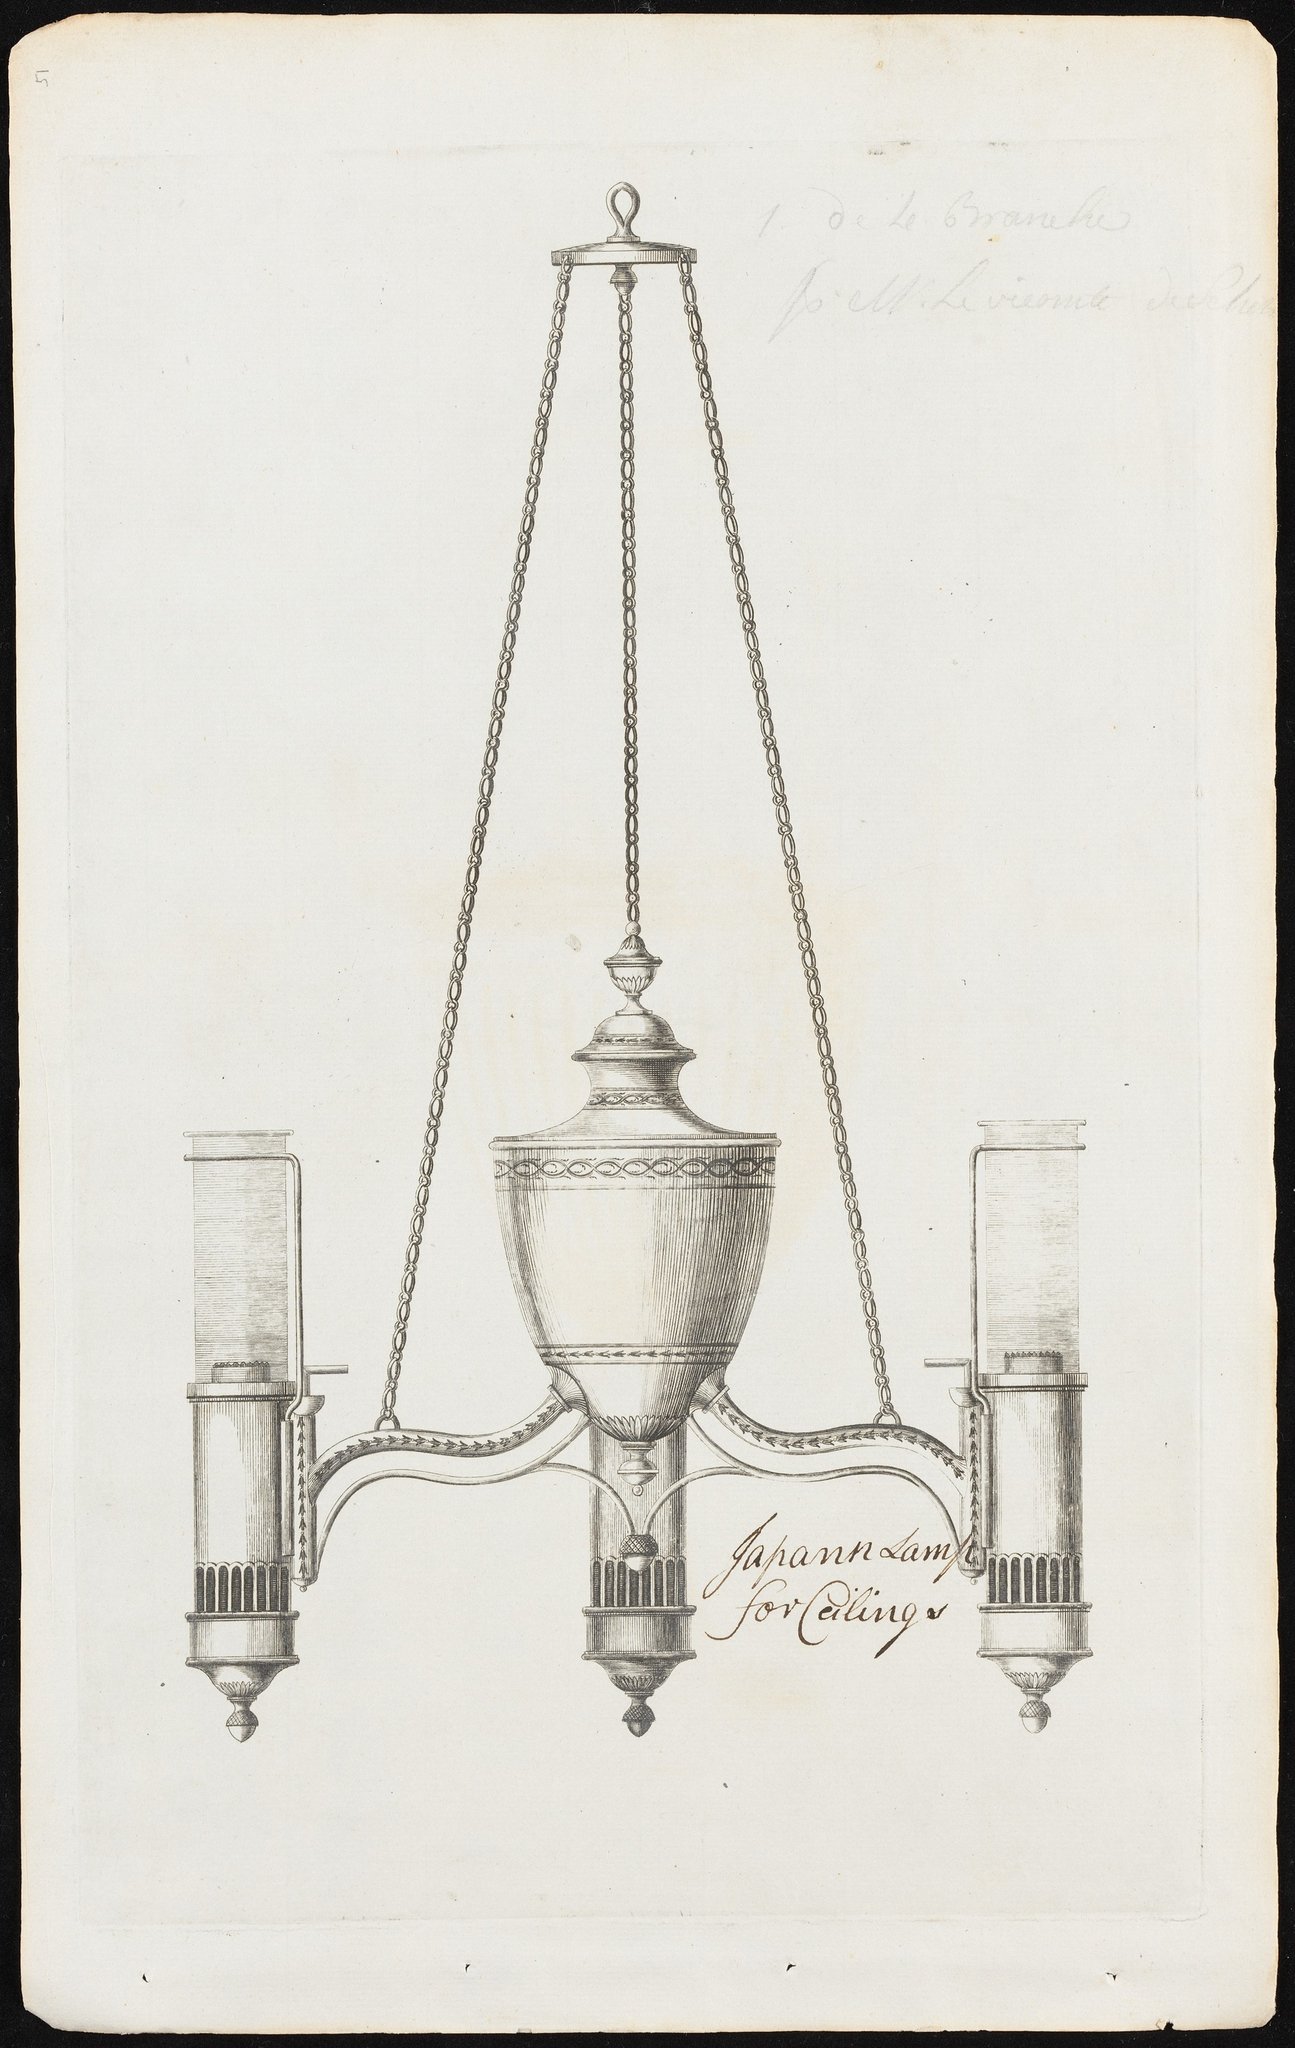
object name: print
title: Japan lamp for ceiling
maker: matthew boulton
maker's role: artist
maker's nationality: british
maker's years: 1728-1809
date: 1790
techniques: etching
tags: lamps